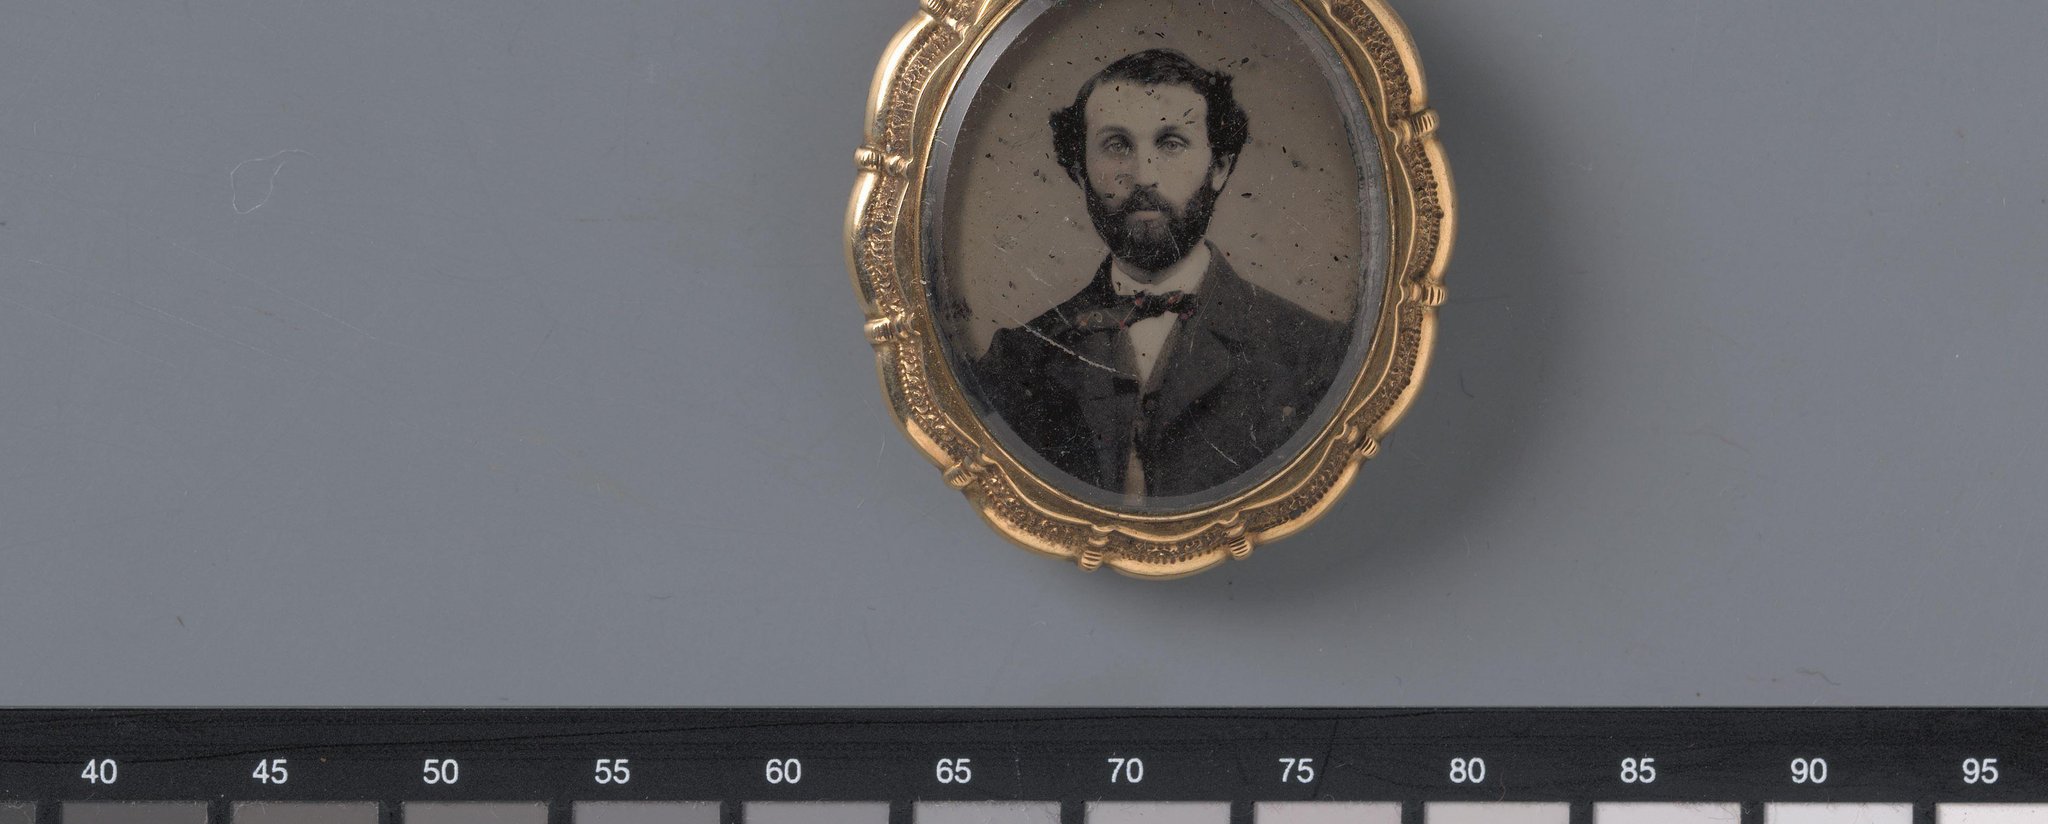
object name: photograph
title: Portret van een onbekende man met baard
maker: Anonymous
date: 1855-1870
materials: glass, metal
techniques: ambrotype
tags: historical persons, beard